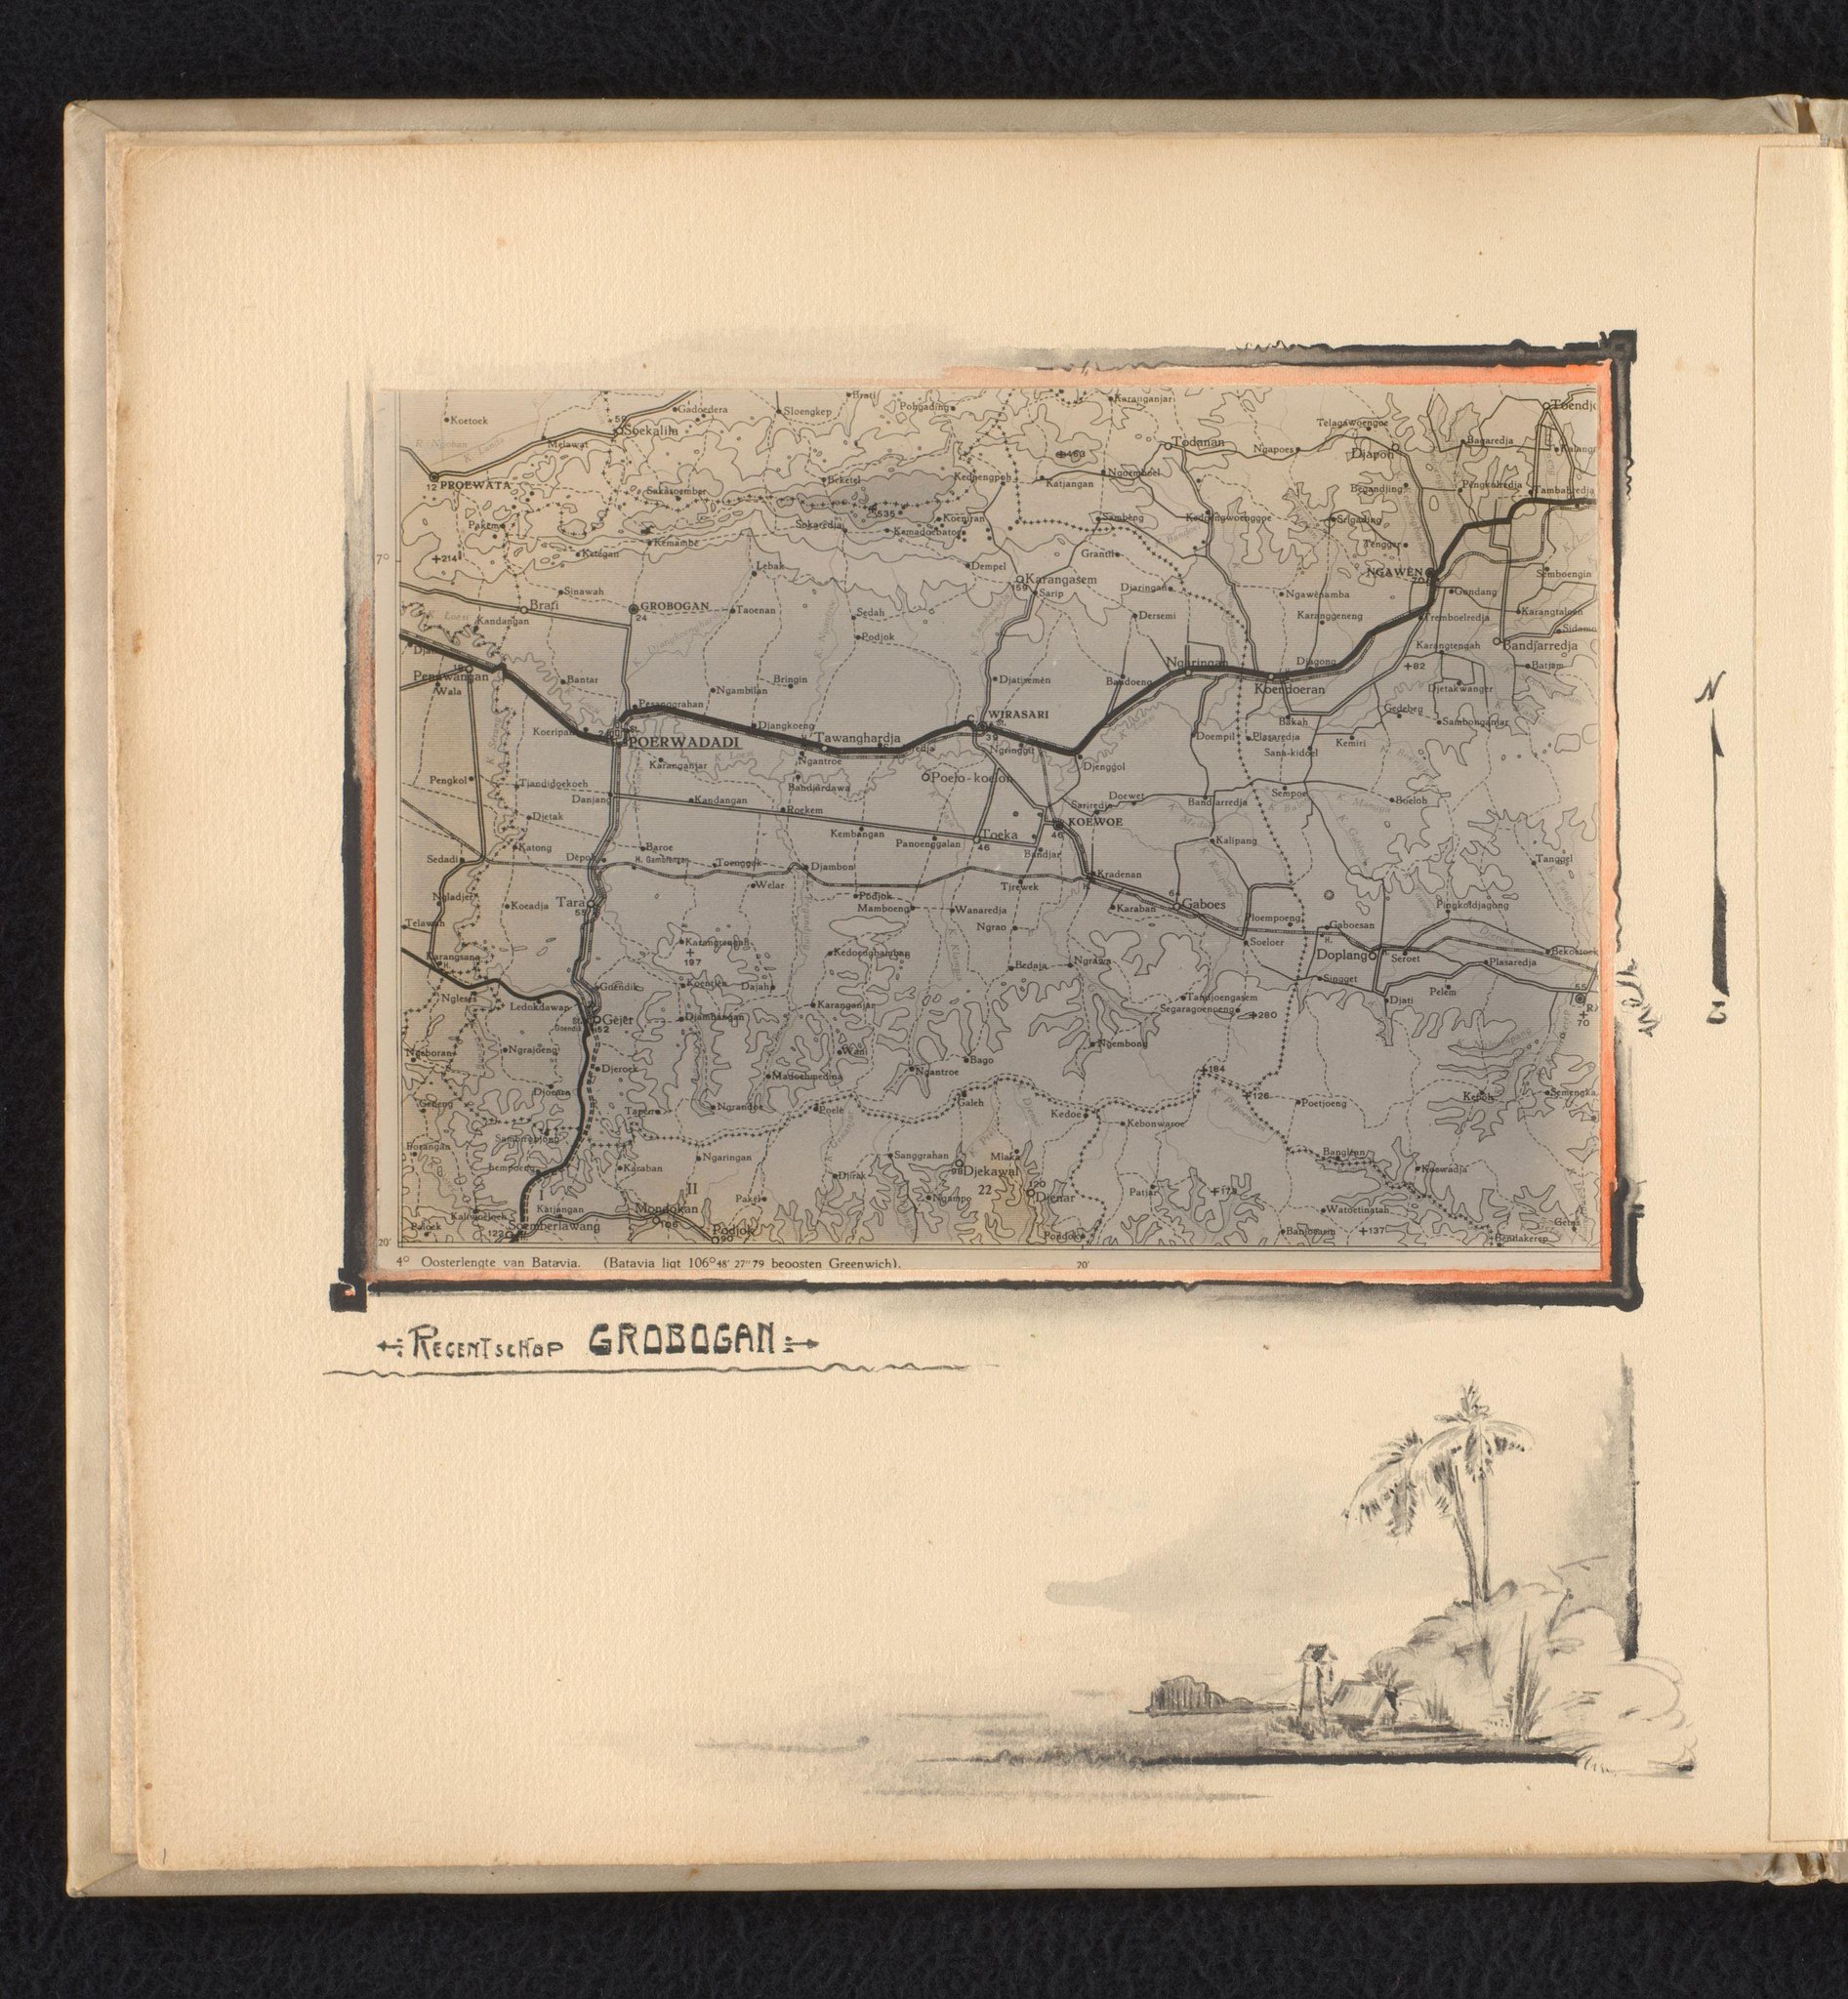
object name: photograph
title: Regentschap Grobogan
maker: Anonymous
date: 1910-1928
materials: paper, photographic support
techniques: drawing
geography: grobogan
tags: maps of separate countries or regions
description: Albumblad met een foto van een kaart van het regentschap Grobogan. Het blad is versierd met een schetsje van een hut onder palmen en randwerk om de foto. Onderdeel van het fotoalbum aangeboden aan J. Habbema door het Binnenlandsch Bestuur Corps van het Regentschap Grobogan, bij het beëindigen van zijn bestuur over het Regentschap, waarschijnlijk in 1928.